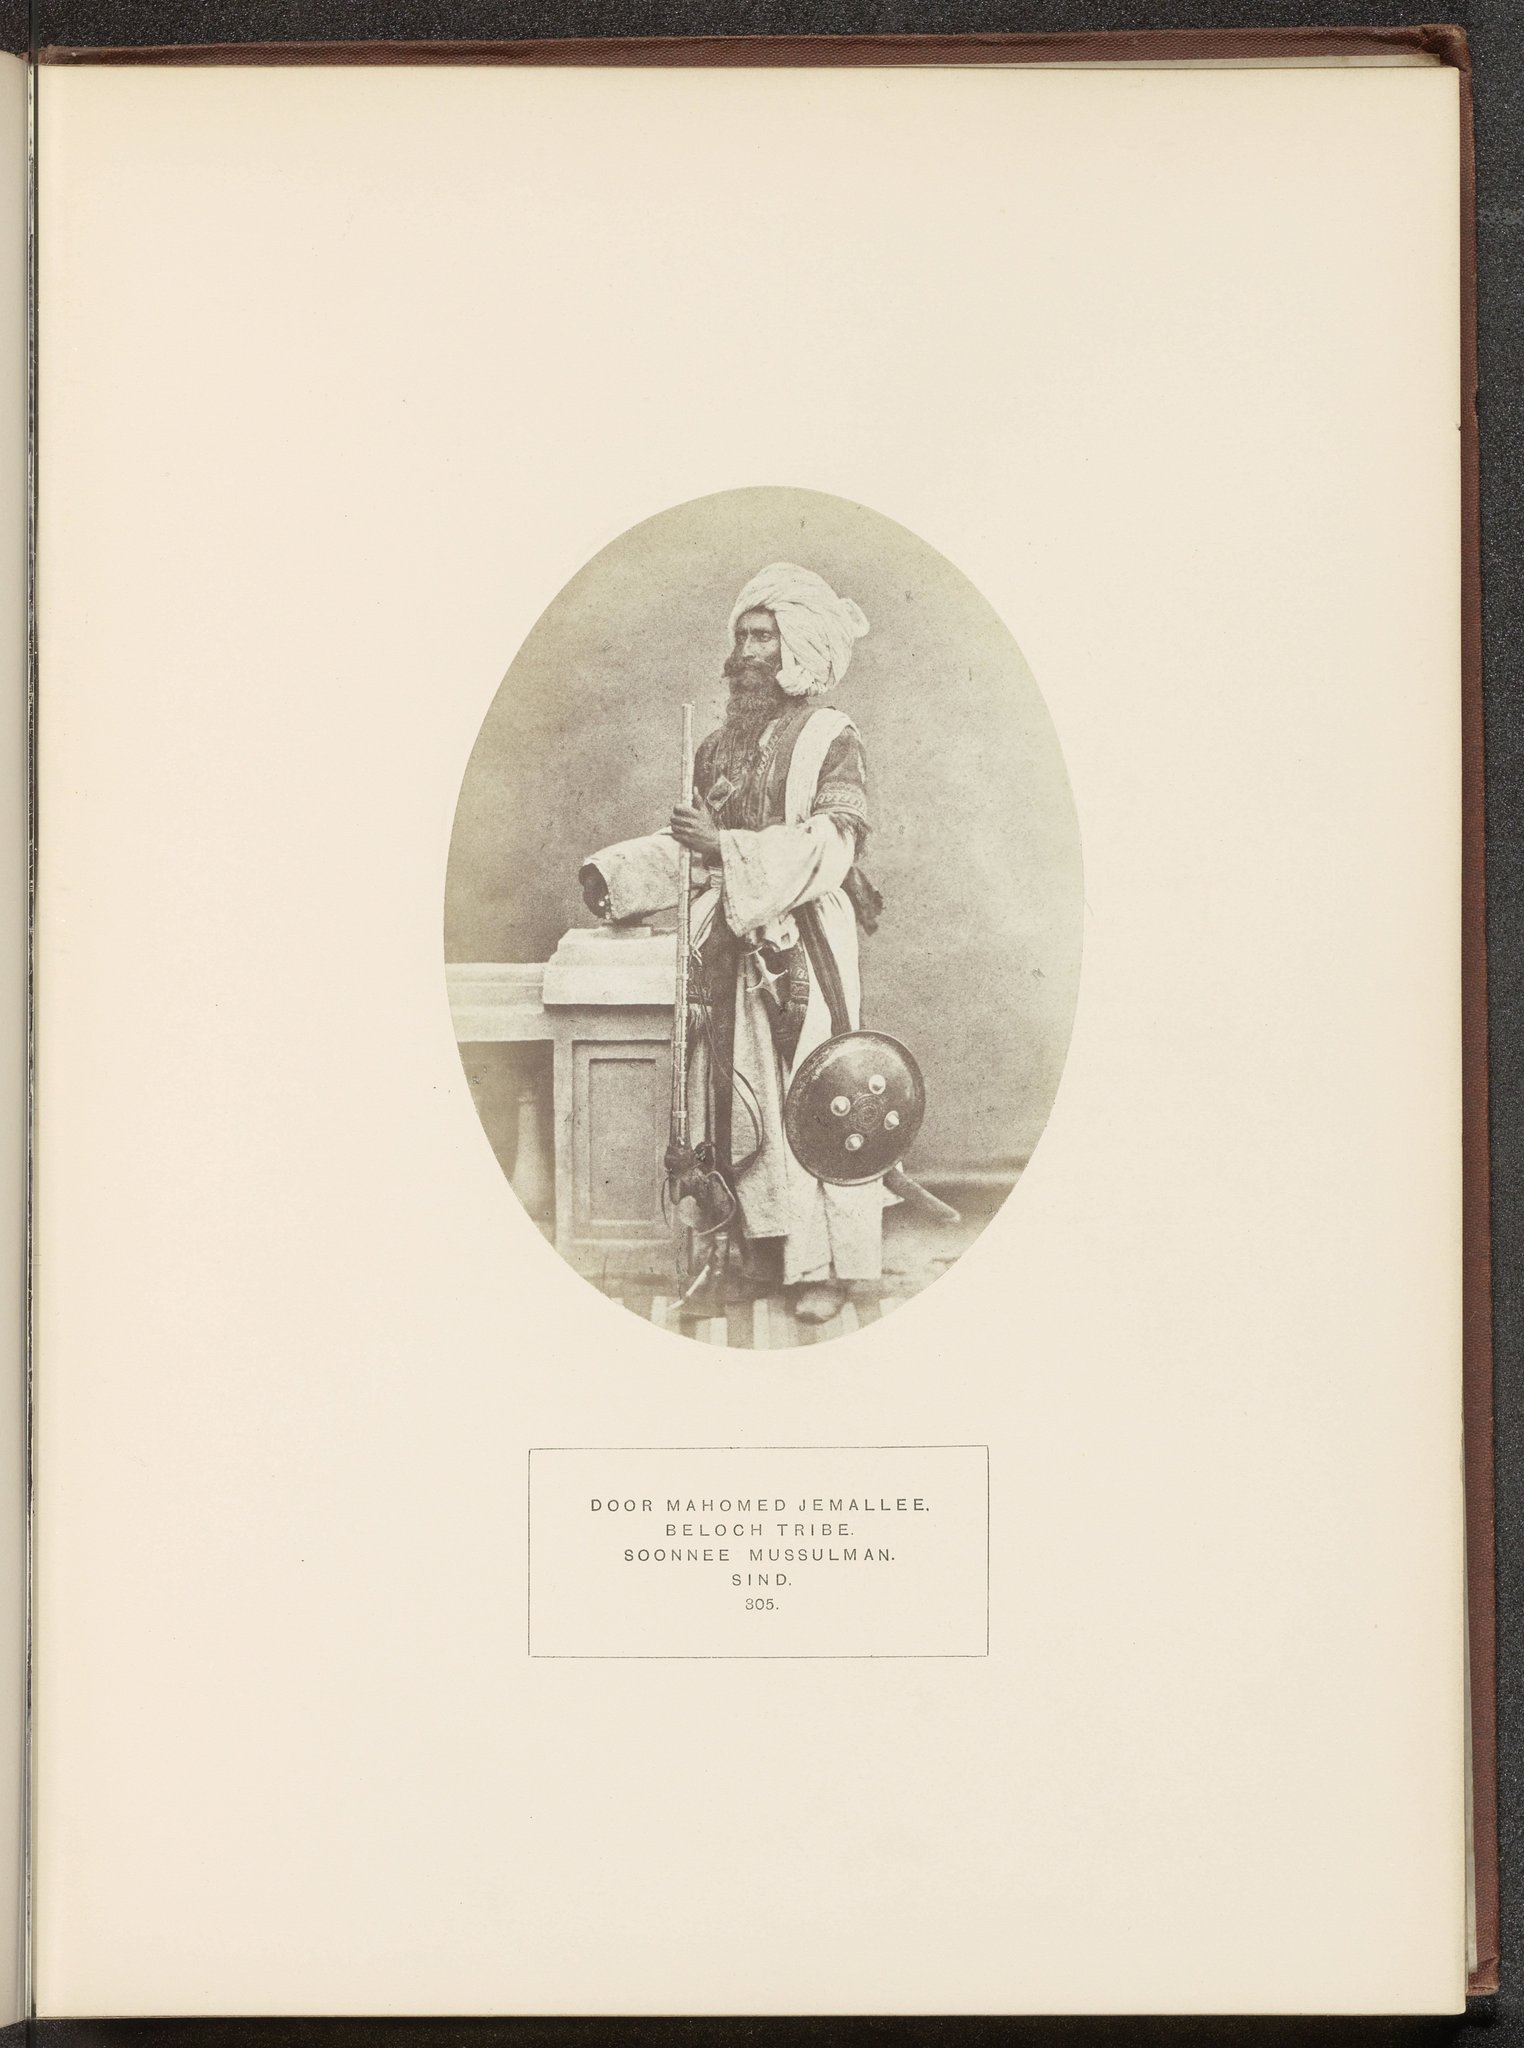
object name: page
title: Portrait of Door Mahomed, a man with weapons and a shield, from the Jamali Baloch tribe in Sindh, Pakistan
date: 1862-1872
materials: photographic support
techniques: albumen print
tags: protective weapons: shield, hacking and thrusting weapons (with name), head-gear: turban, firearms: rifle, human races; peoples; nationalities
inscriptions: inscription: ‘DOOR MAHOMED JEMALLEE./ BELOCH TRIBE./ SOONNEE MUSSULMAN./ SIND.’, number: ‘305.’